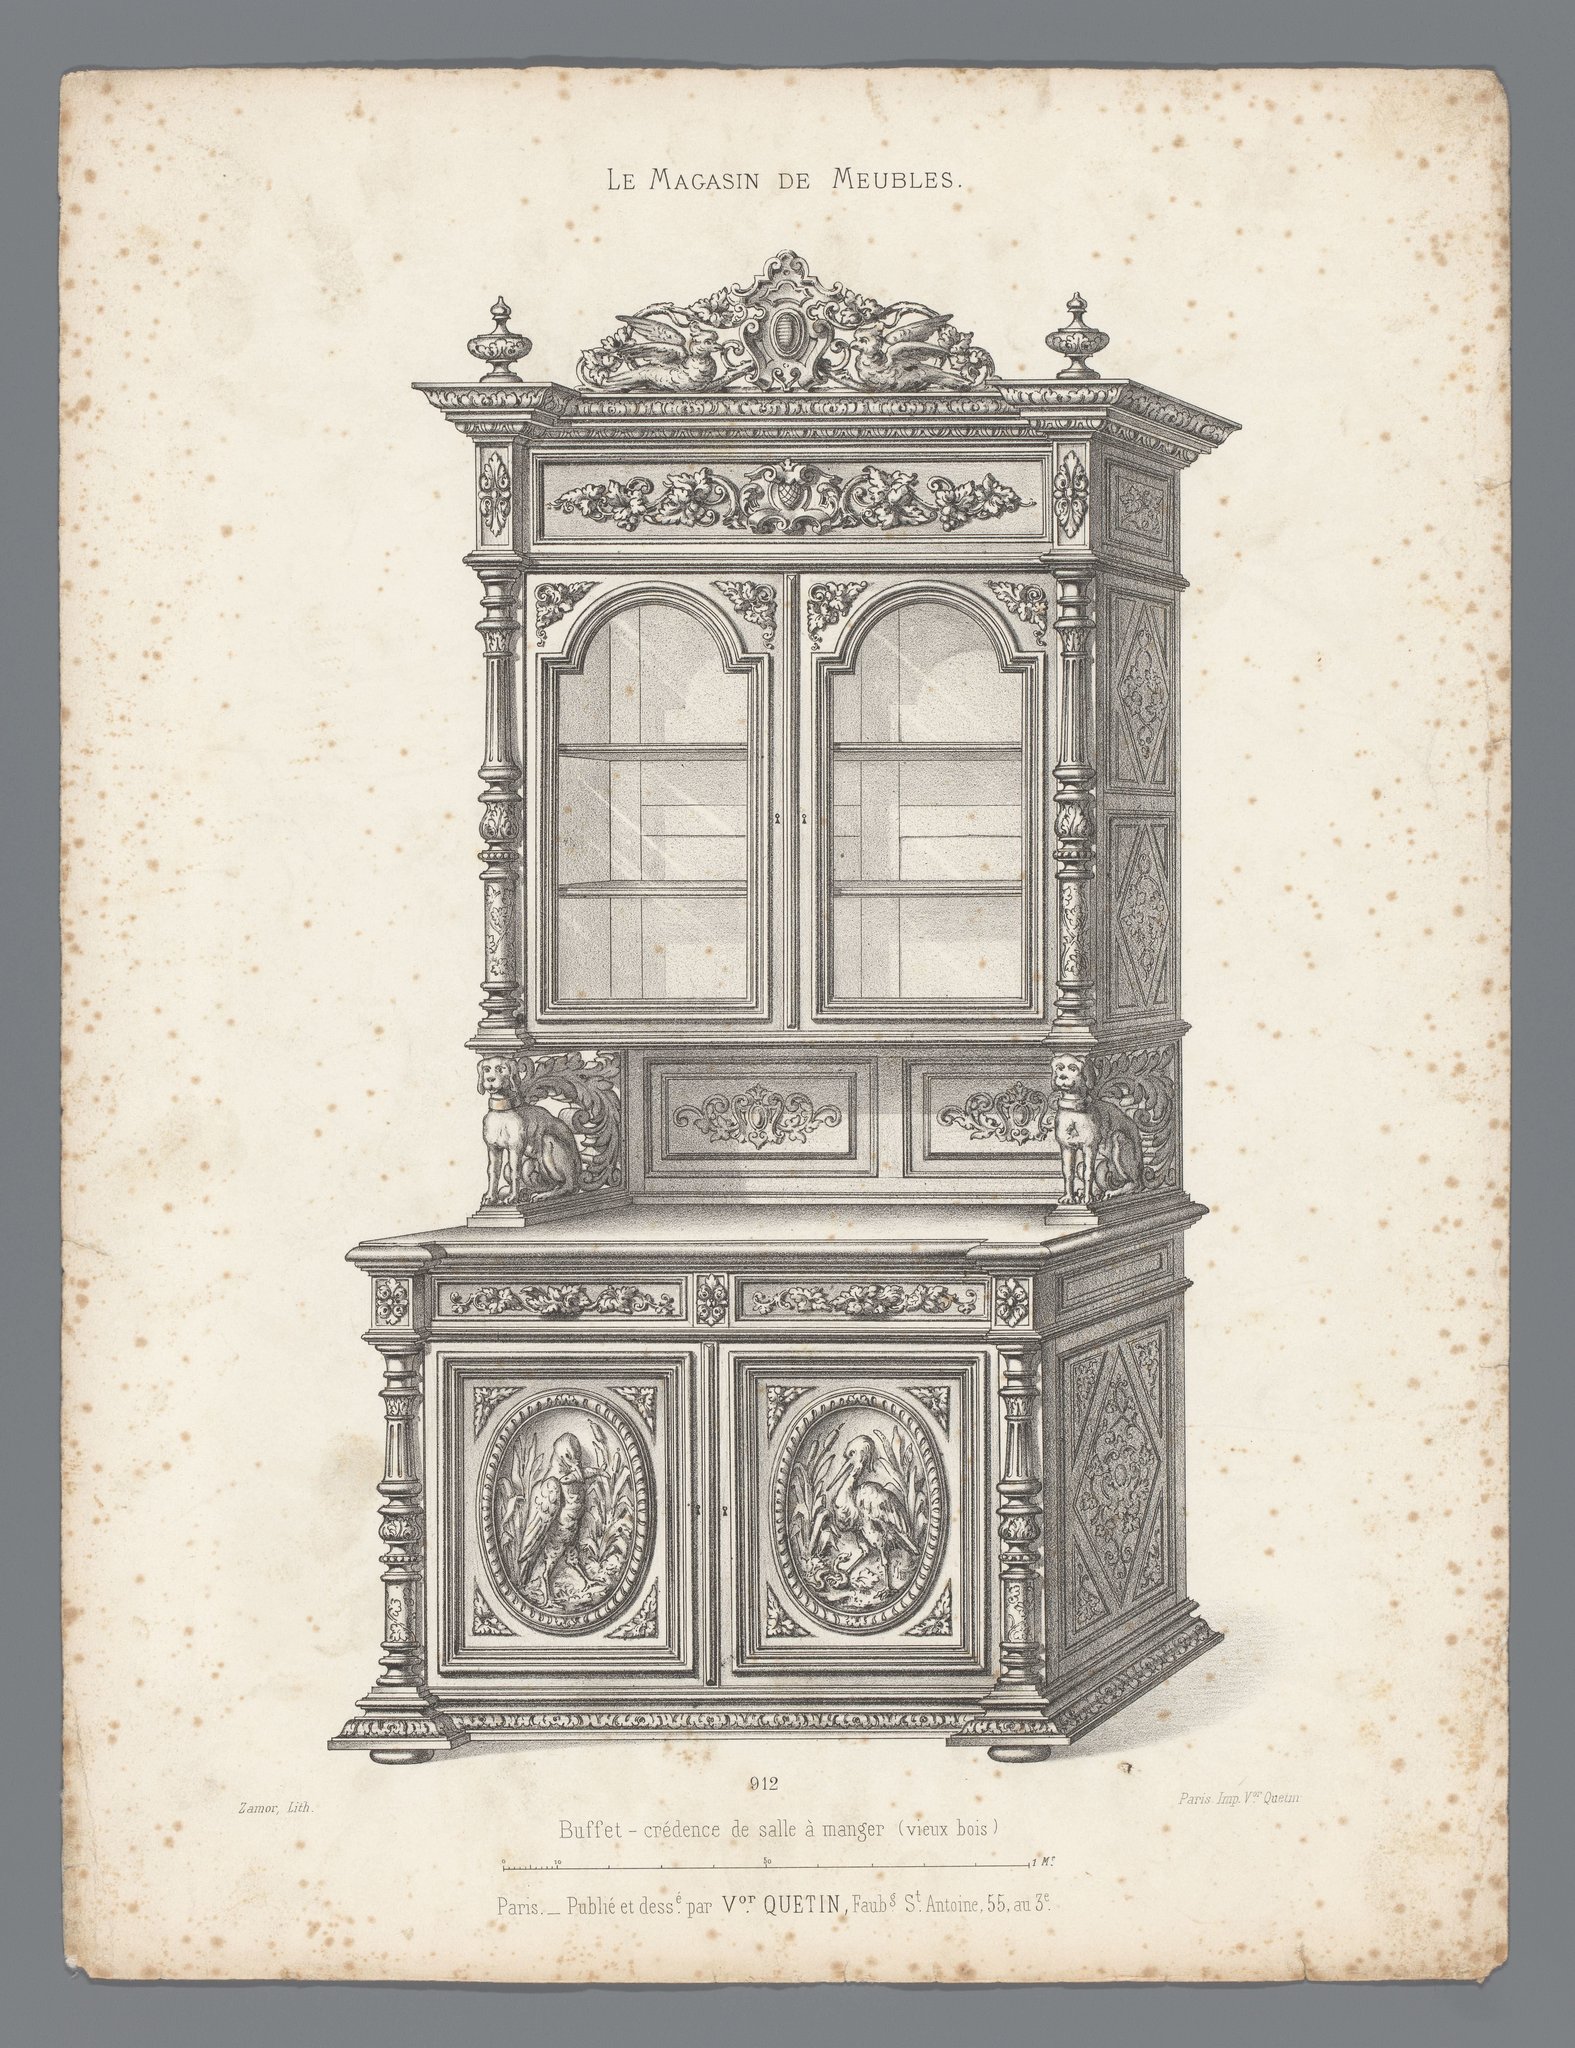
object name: print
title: Buffetkast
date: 1832-1877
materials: paper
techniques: lithograph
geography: paris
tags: furniture for storage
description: Een buffetkast, bestemd voor een eetkamer.